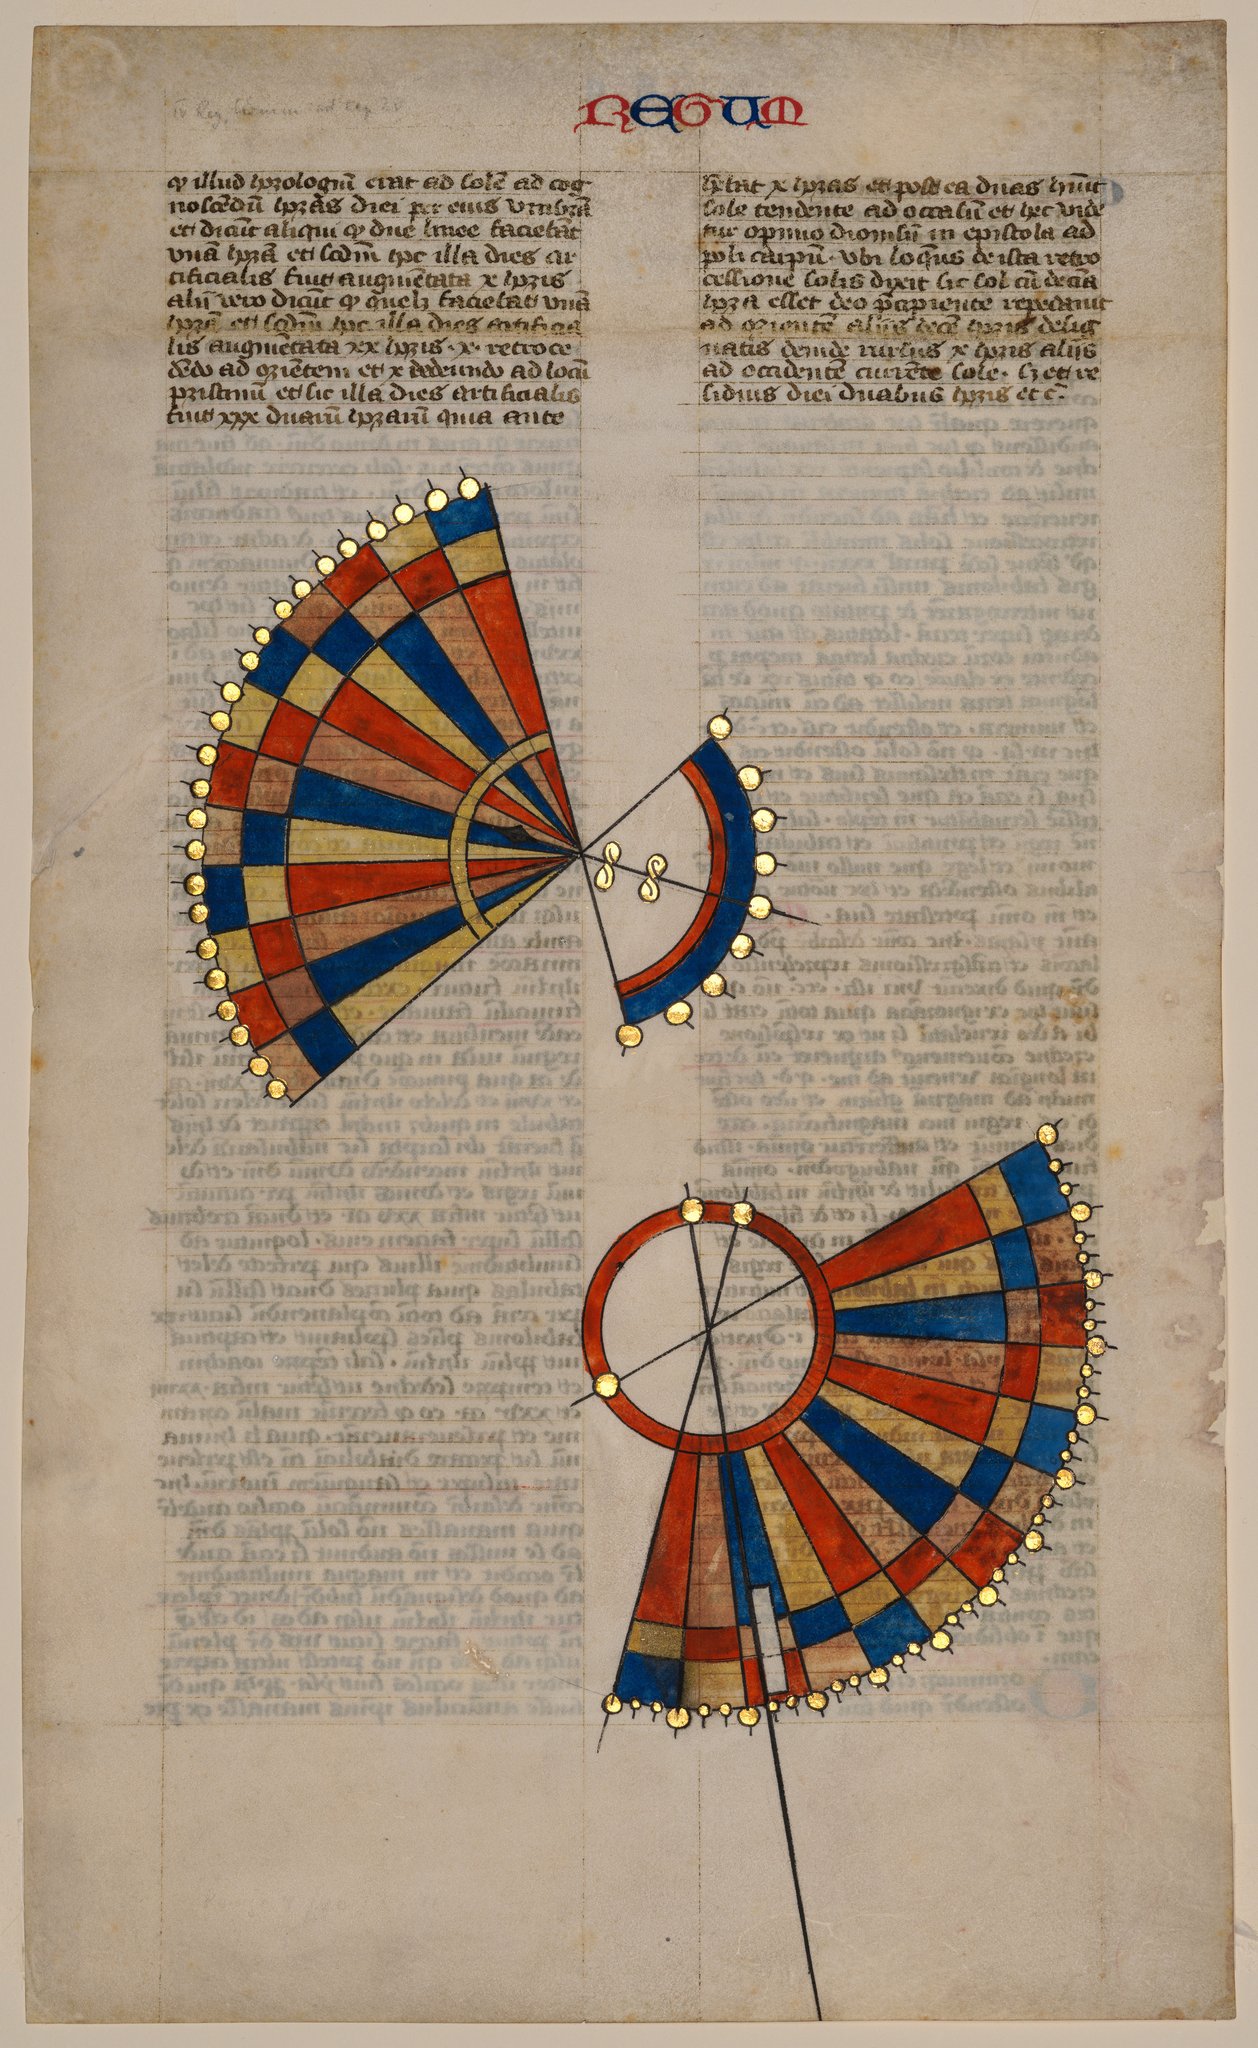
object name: manuscript leaf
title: Sundial of Ahaz, leaf from the Postilla Litteralis (Literal Commentary) of Nicholas of Lyra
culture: french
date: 1360-1380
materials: gold, ink, iron, parchment, watercolor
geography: france